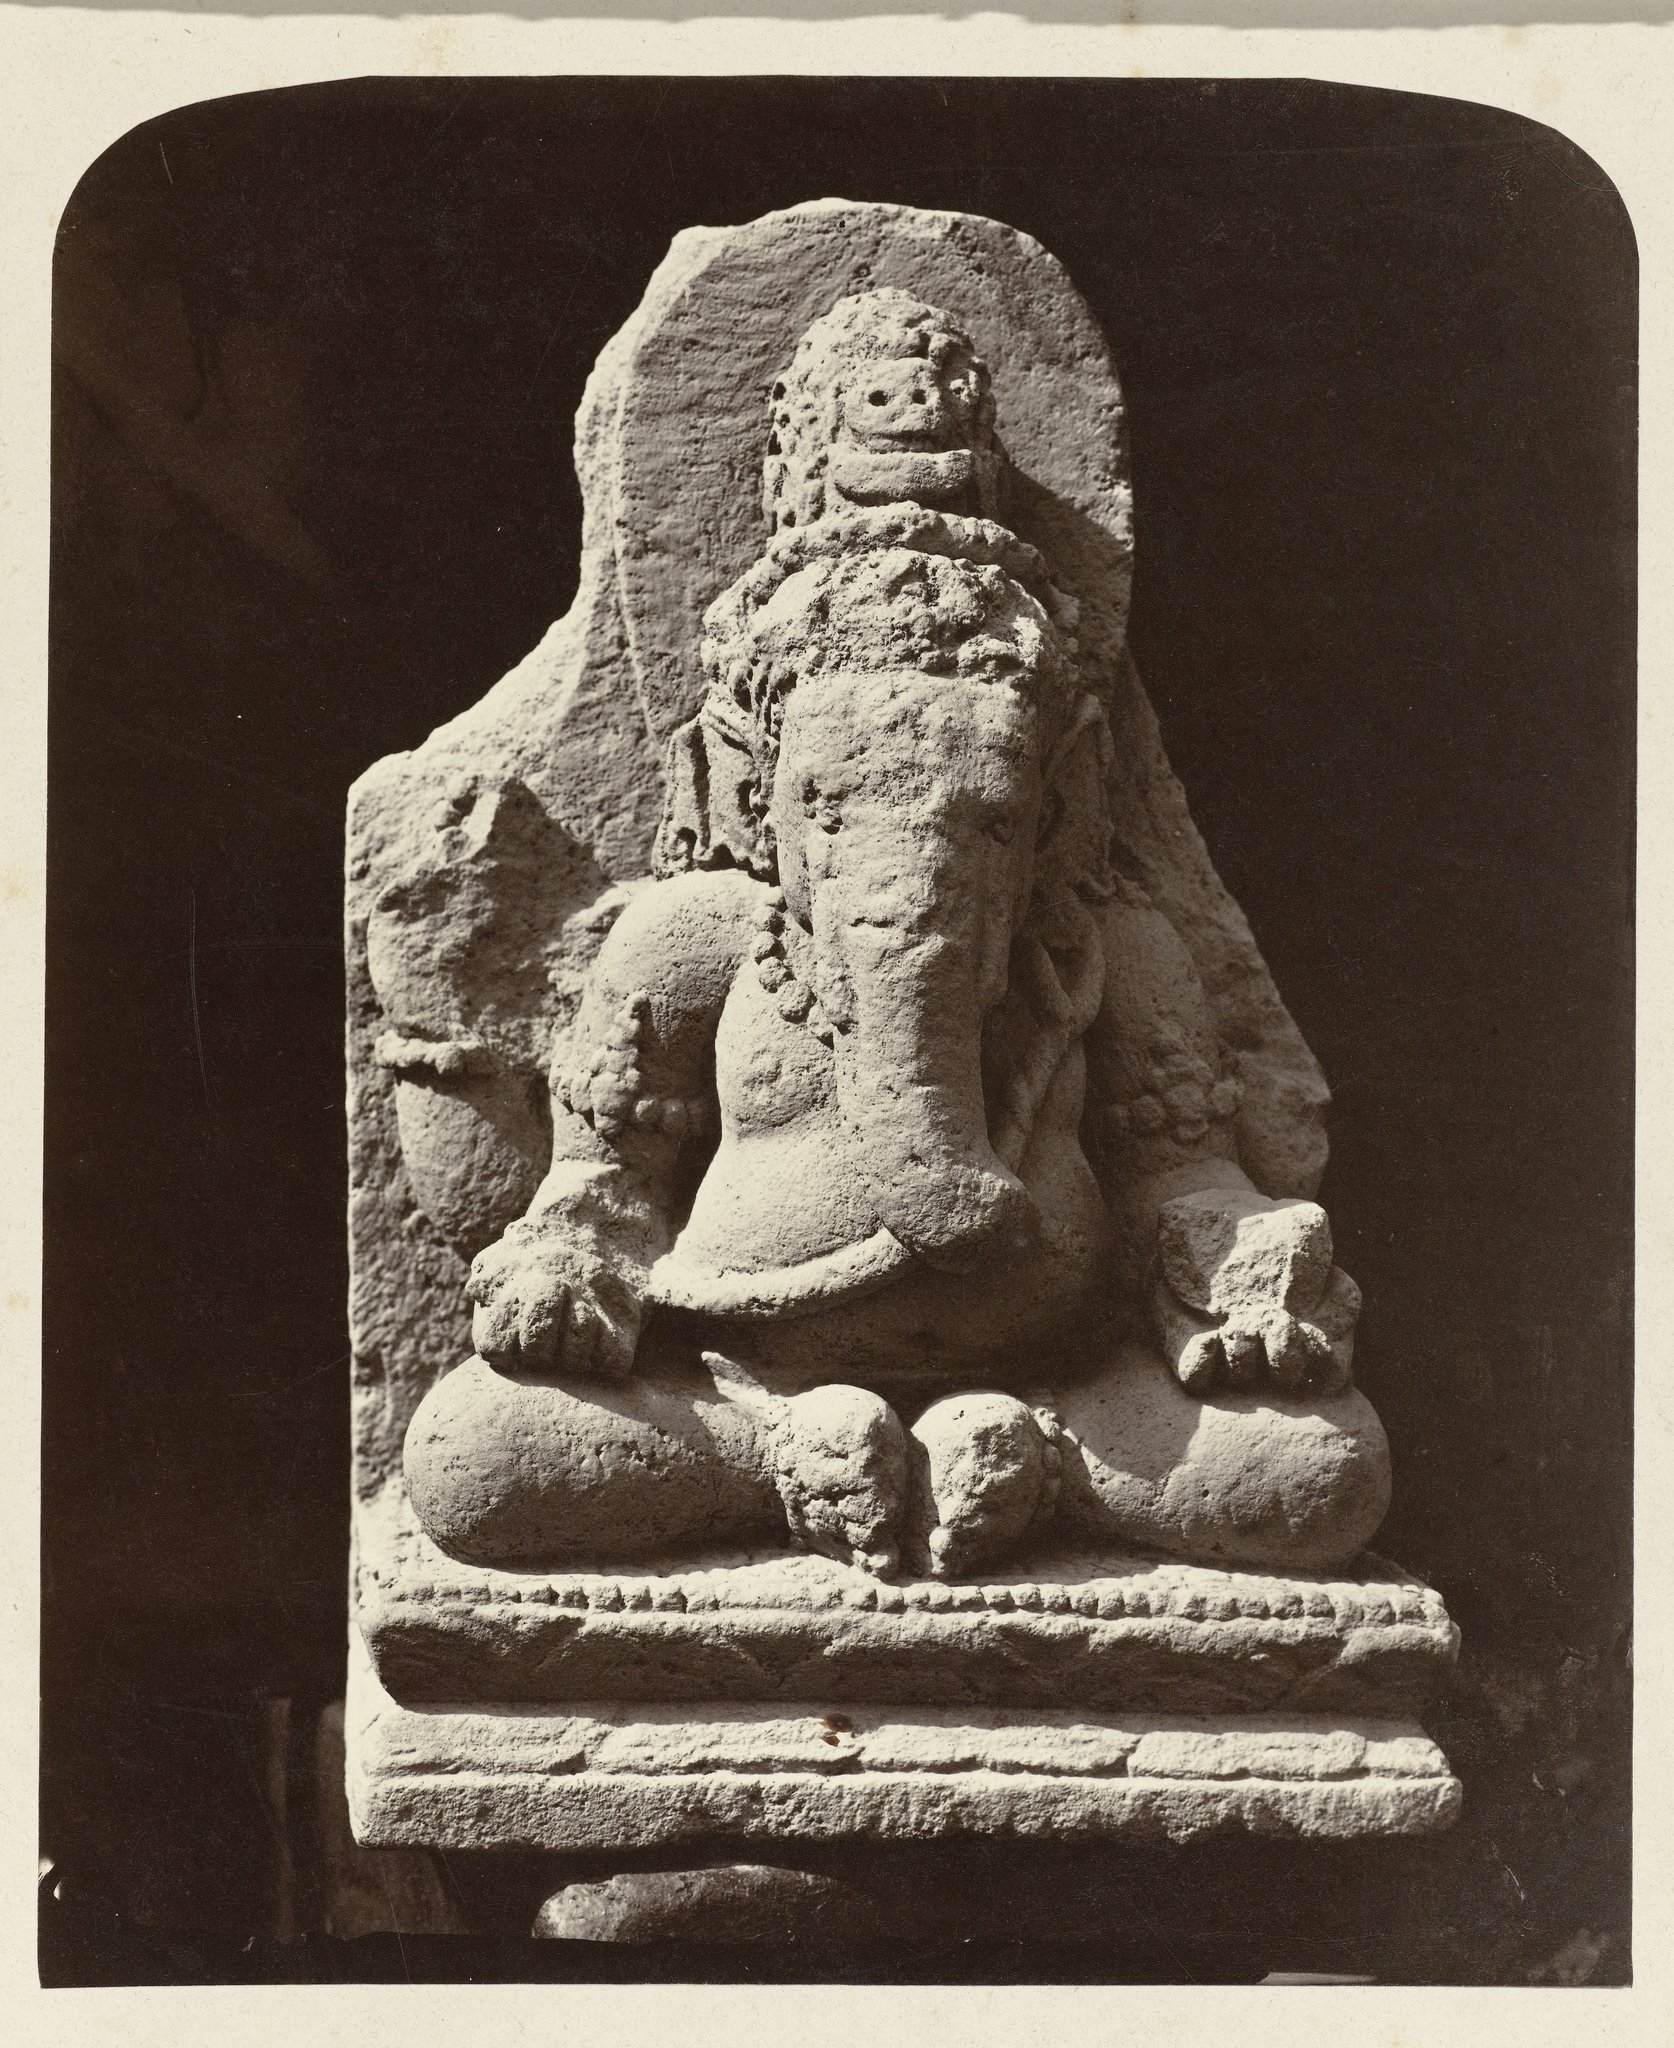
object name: photograph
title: Four armed Ganesha exhibited in the garden of the assistent-resident of Wonosobo (provenance Dieng plateau). Wonosobo, Wonosobo district, Central Java province, 10th century.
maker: isidore kinsbergen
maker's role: fotograaf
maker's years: 1821-1905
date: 1808-1864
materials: cardboard, paper, photographic support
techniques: albumen print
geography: java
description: Een vier armige Ganesha, tentoongesteld in de tuin van de assistent resident in Wonosobo.